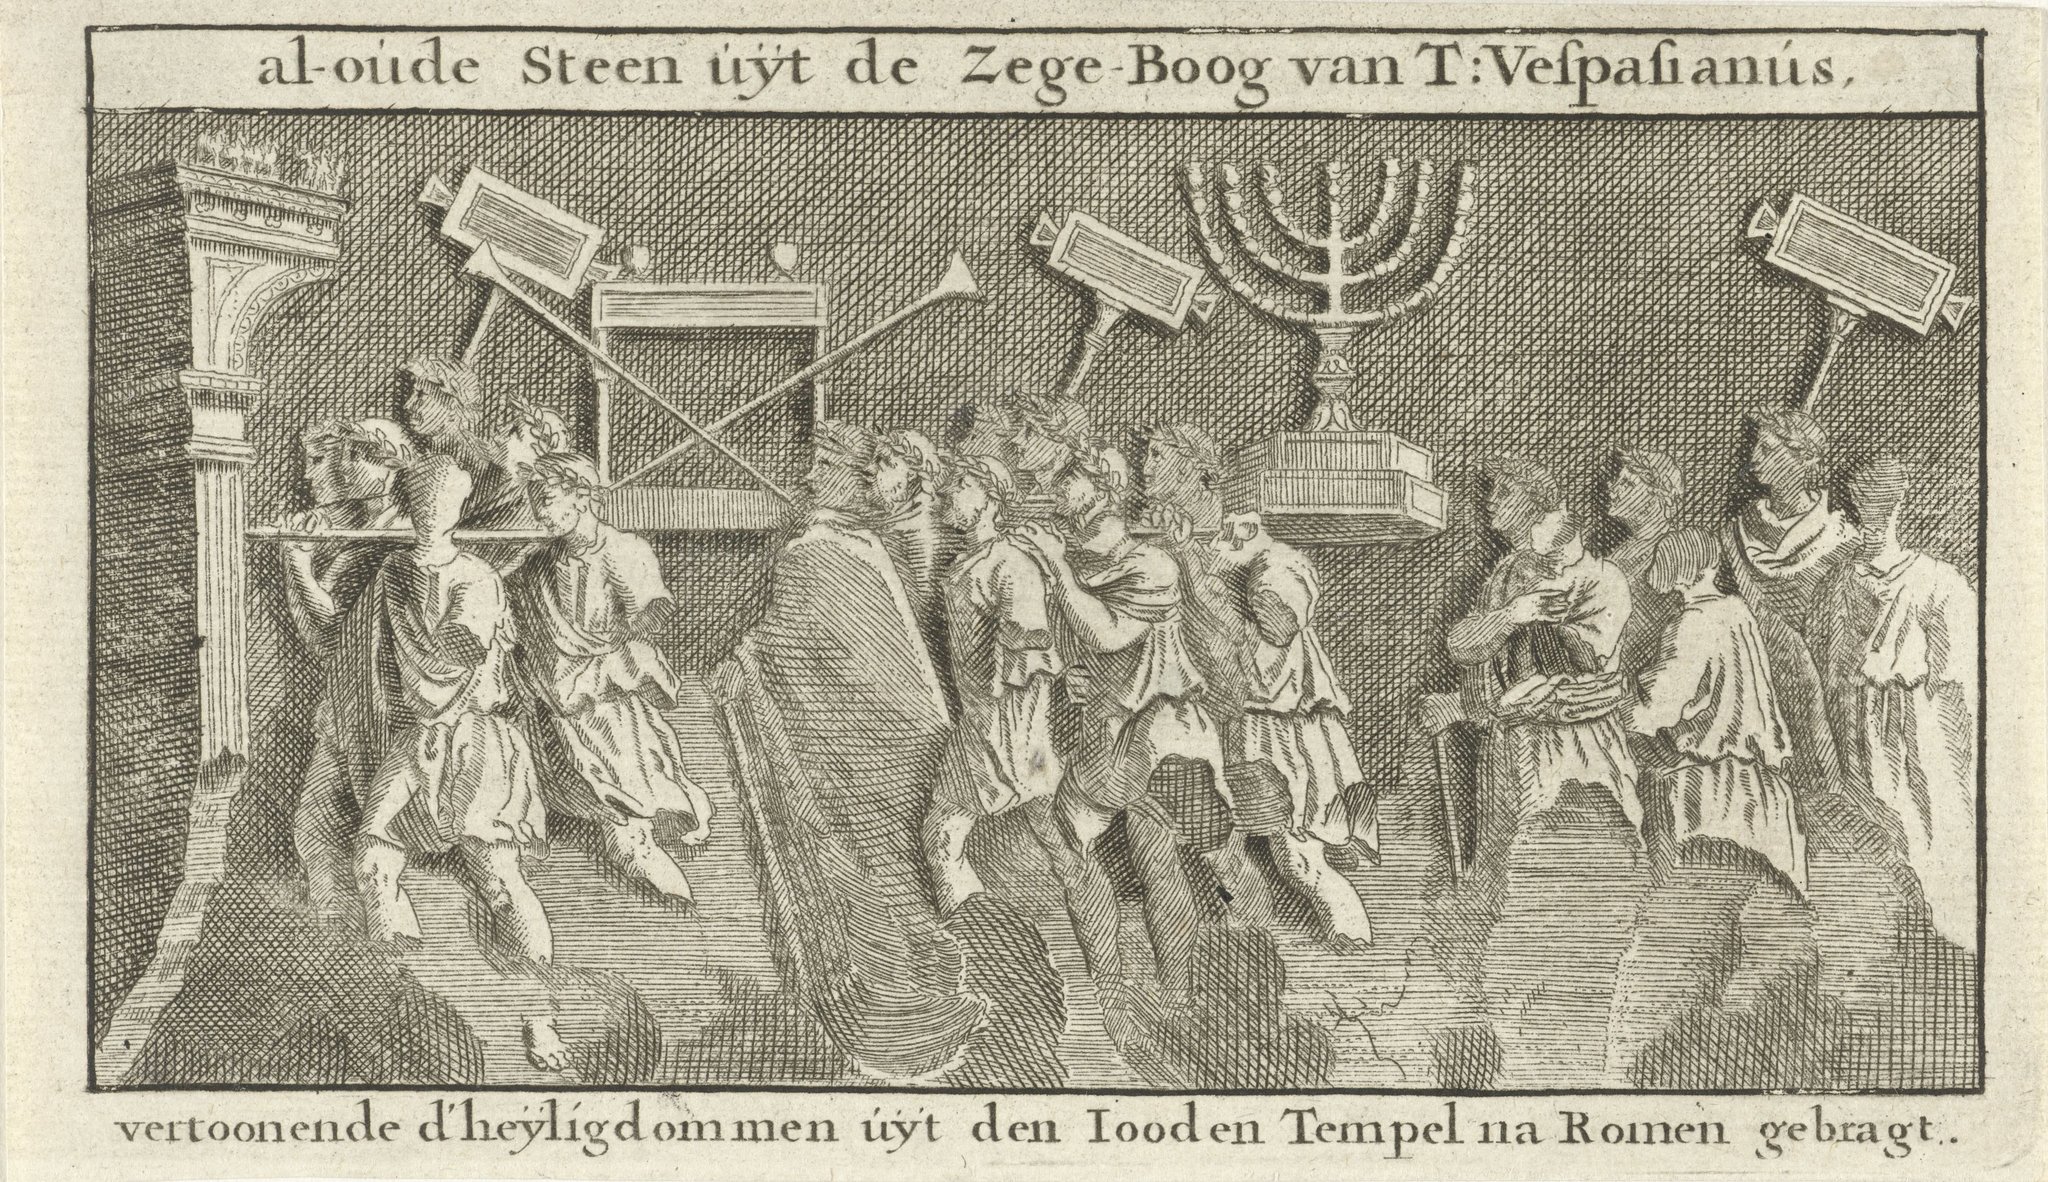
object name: print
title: al-oude Steen, uijt de Zege-Boog van T: Vespasianus, vertoonende d'heijligdommen uijt den Iooden Tempel na Romen gebragt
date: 1682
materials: paper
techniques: etching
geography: amsterdam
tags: triumphal arch, piece of sculpture, reproduction of a piece of sculpture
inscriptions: collector's mark: Lugt 2233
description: Illustratie opgenomen in: Cunaeus, Petrus. De republyk der Hebreen, of gemeenebest der joden, 3 delen. Amsterdam: Wilhelmus Goeree, 1682, dl. 1, p. 260.